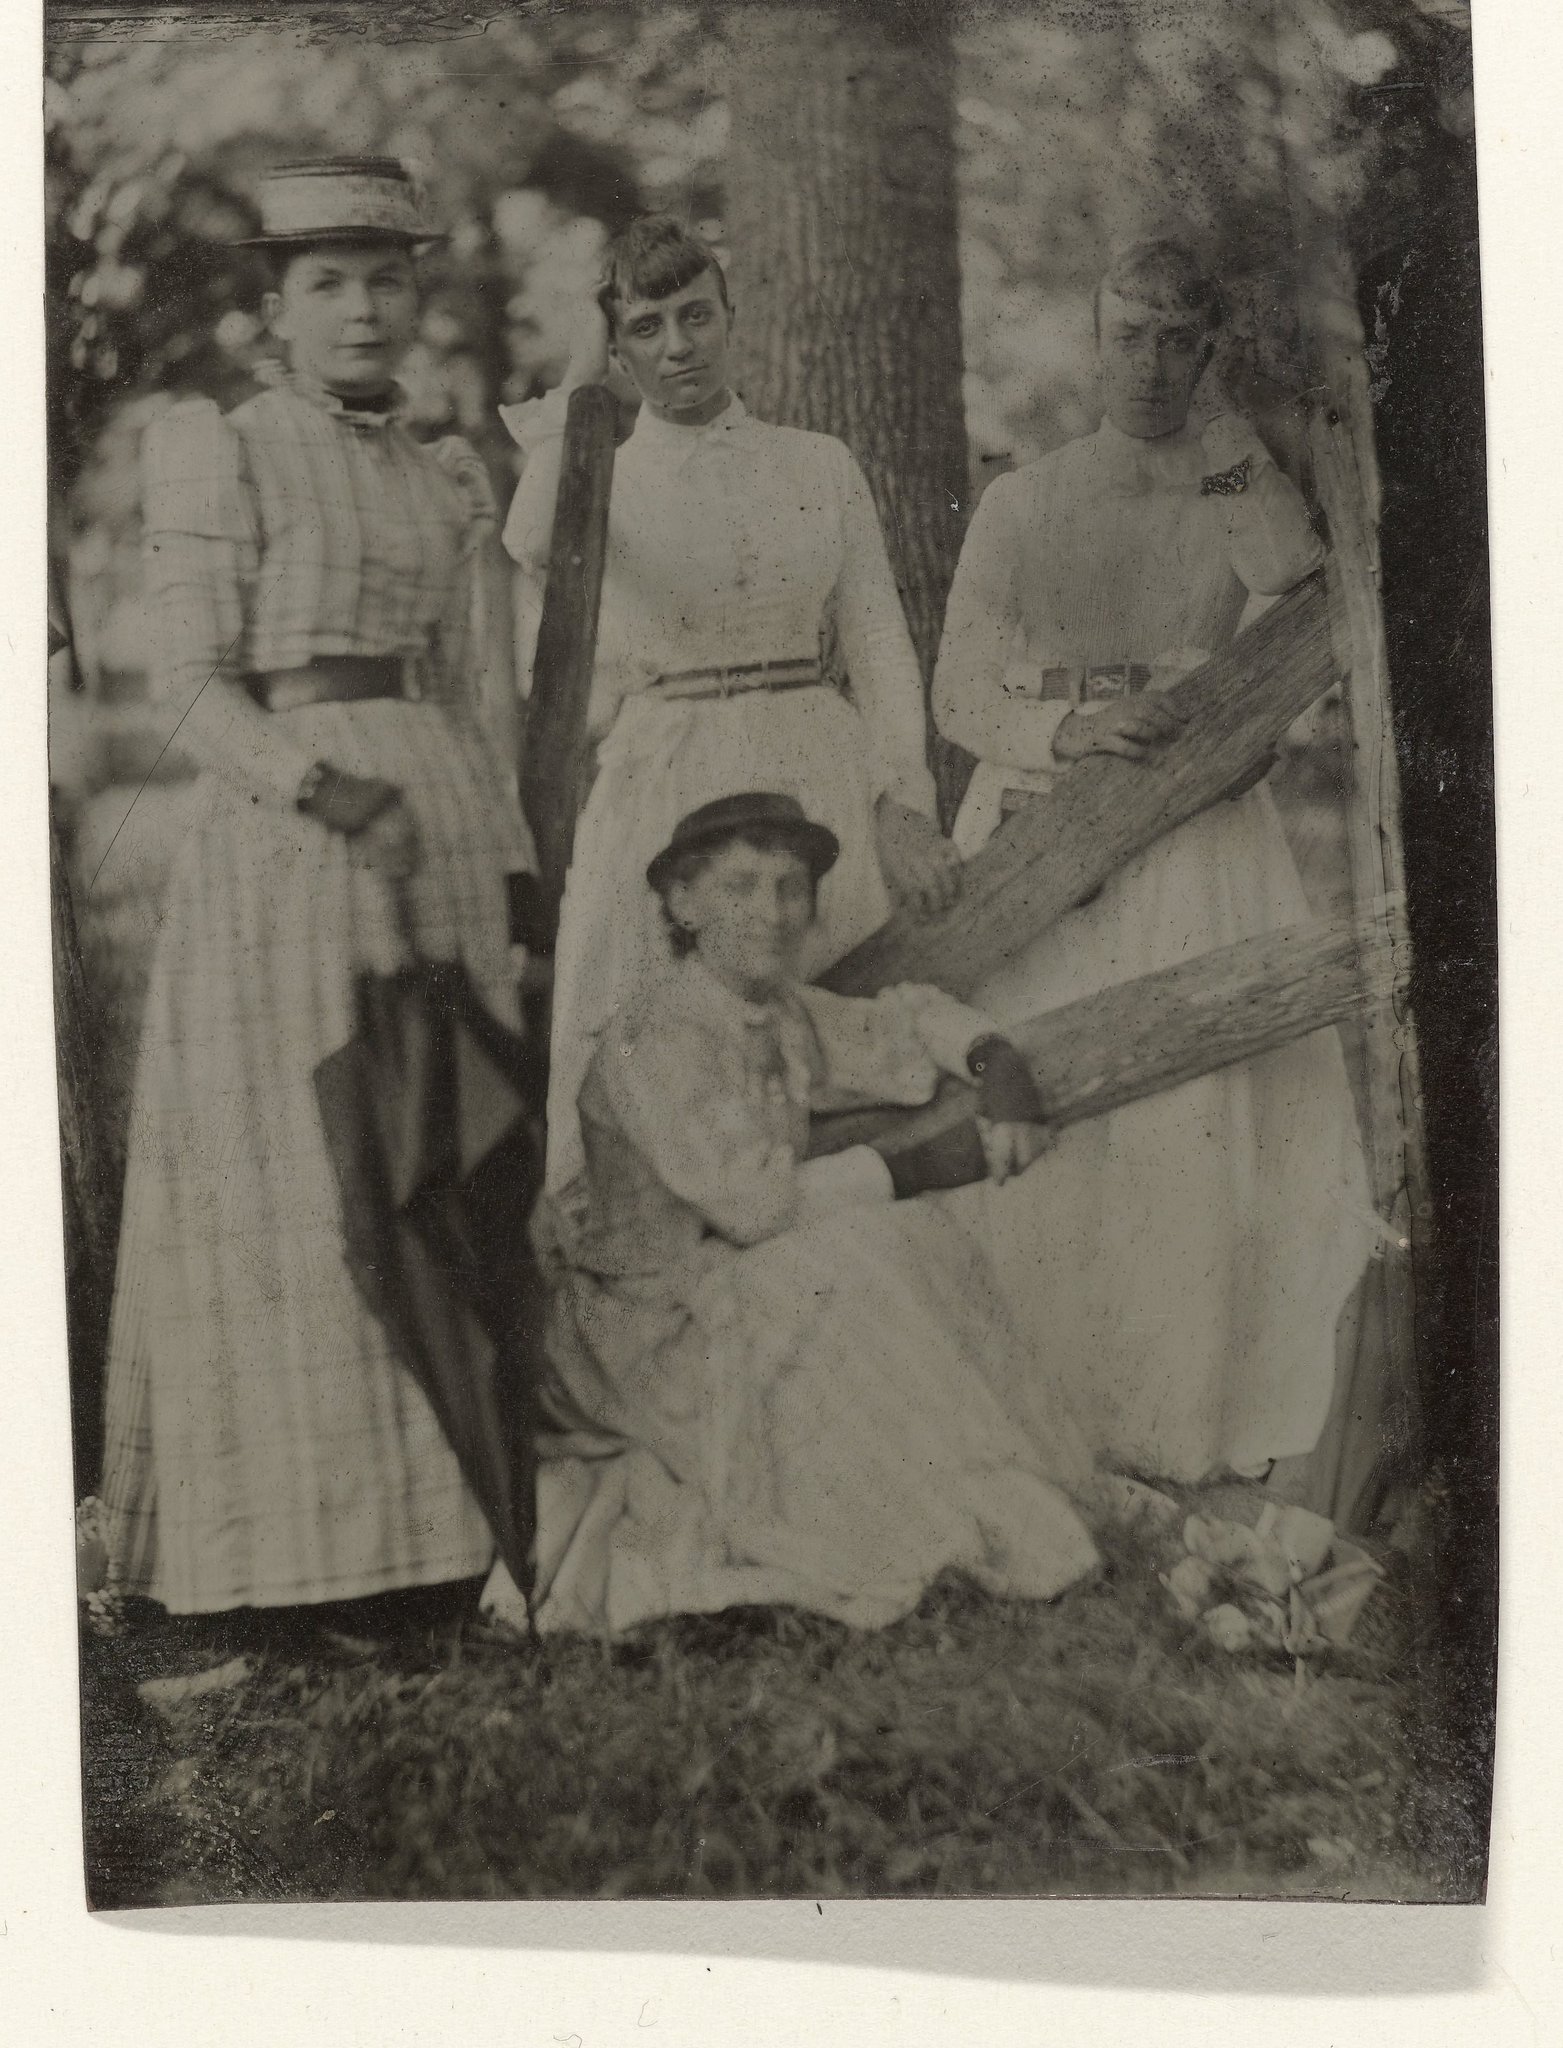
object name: photograph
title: Portret van vier vrouwen bij een hek en bomen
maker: Anonymous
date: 1860-1900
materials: metal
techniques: ferrotyping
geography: north and central america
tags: historical persons not known by name - bb - woman